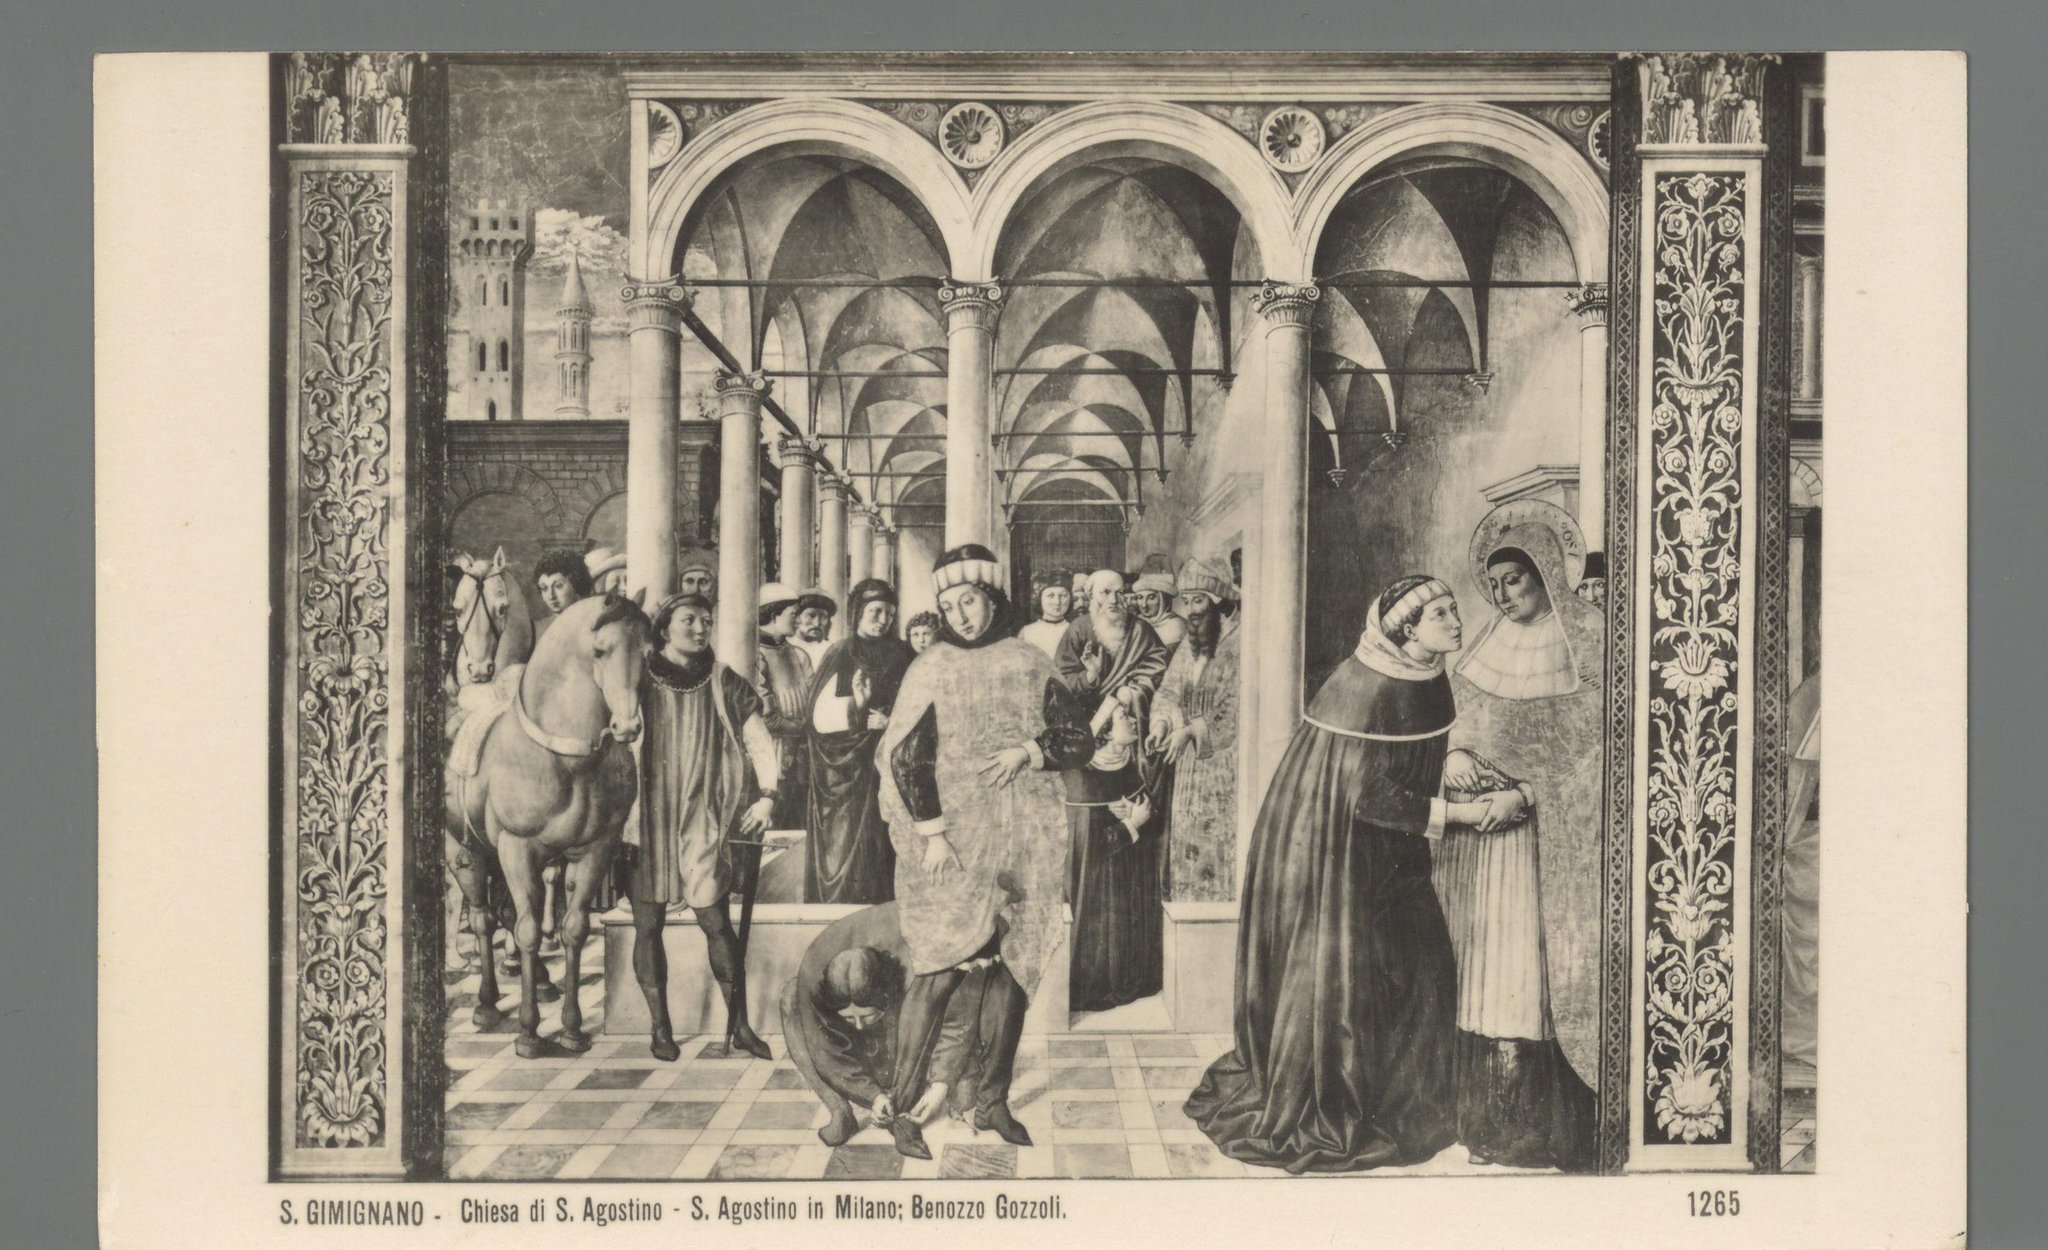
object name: ansichtkaart, prentbriefkaart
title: S. Gimignano - Chiesa di S. Agostino - S. Agostino in Milano; Benozzo Gozzoli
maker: Anonymous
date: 1906-1930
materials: paper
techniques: gelatin silver print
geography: san gimignano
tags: interior of church, picture, painting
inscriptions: collector's mark: ‘AFE v S’